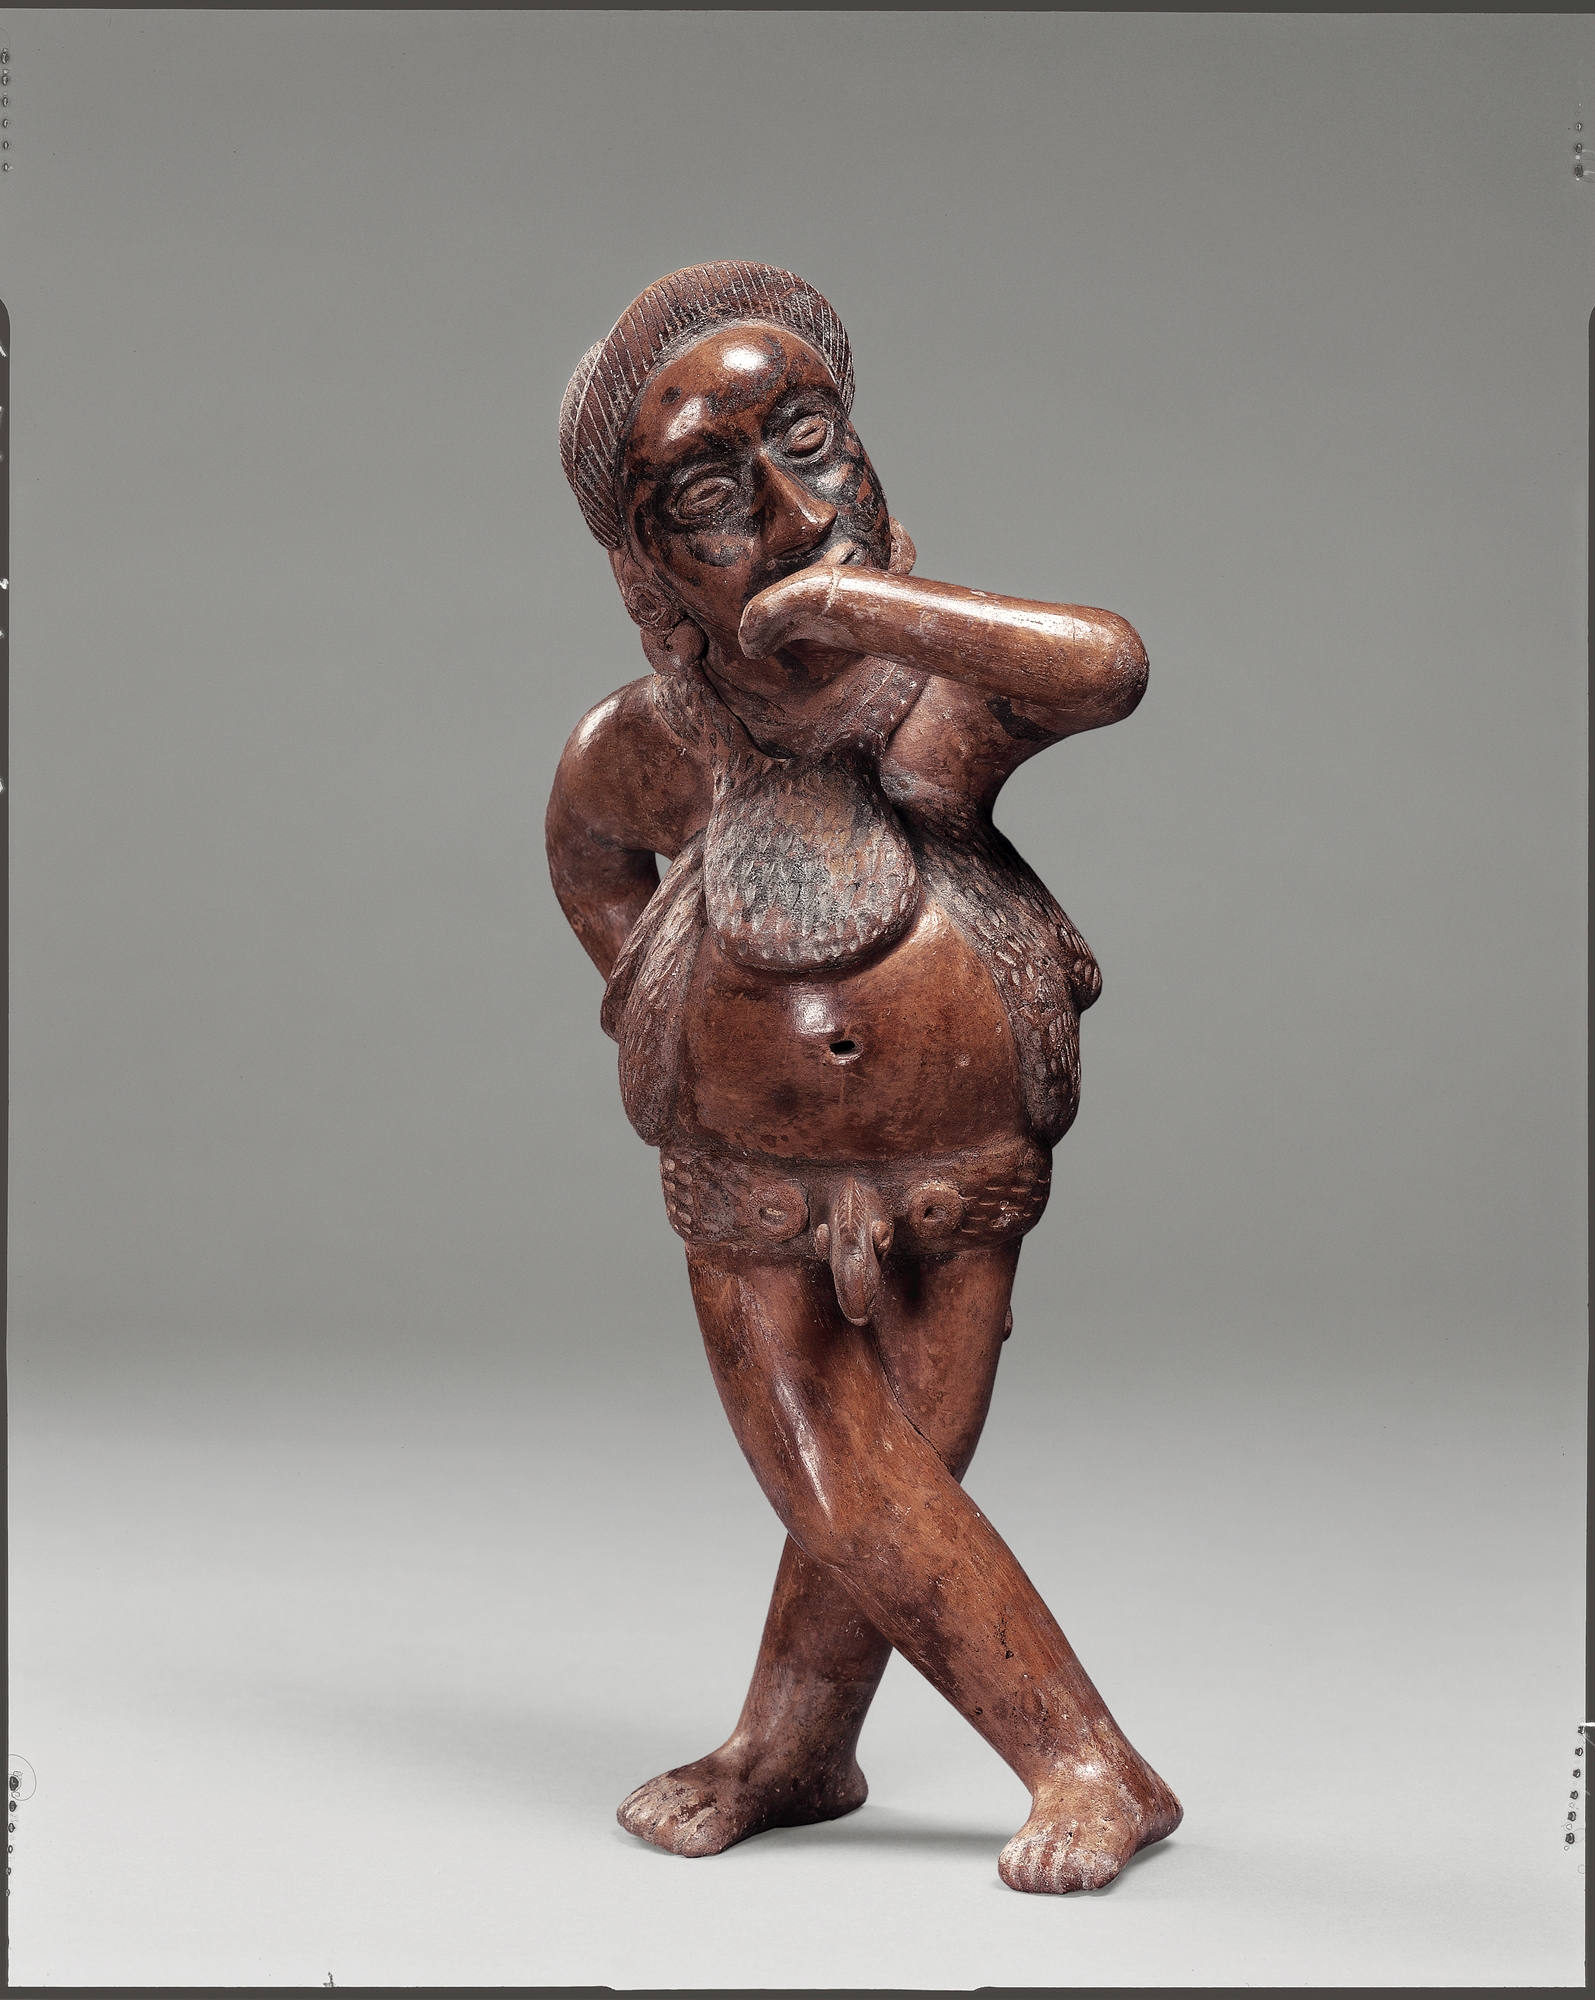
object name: male figure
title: Dancer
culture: jalisco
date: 100 BCE-300 CE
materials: ceramic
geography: mexico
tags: male nudes,dancers